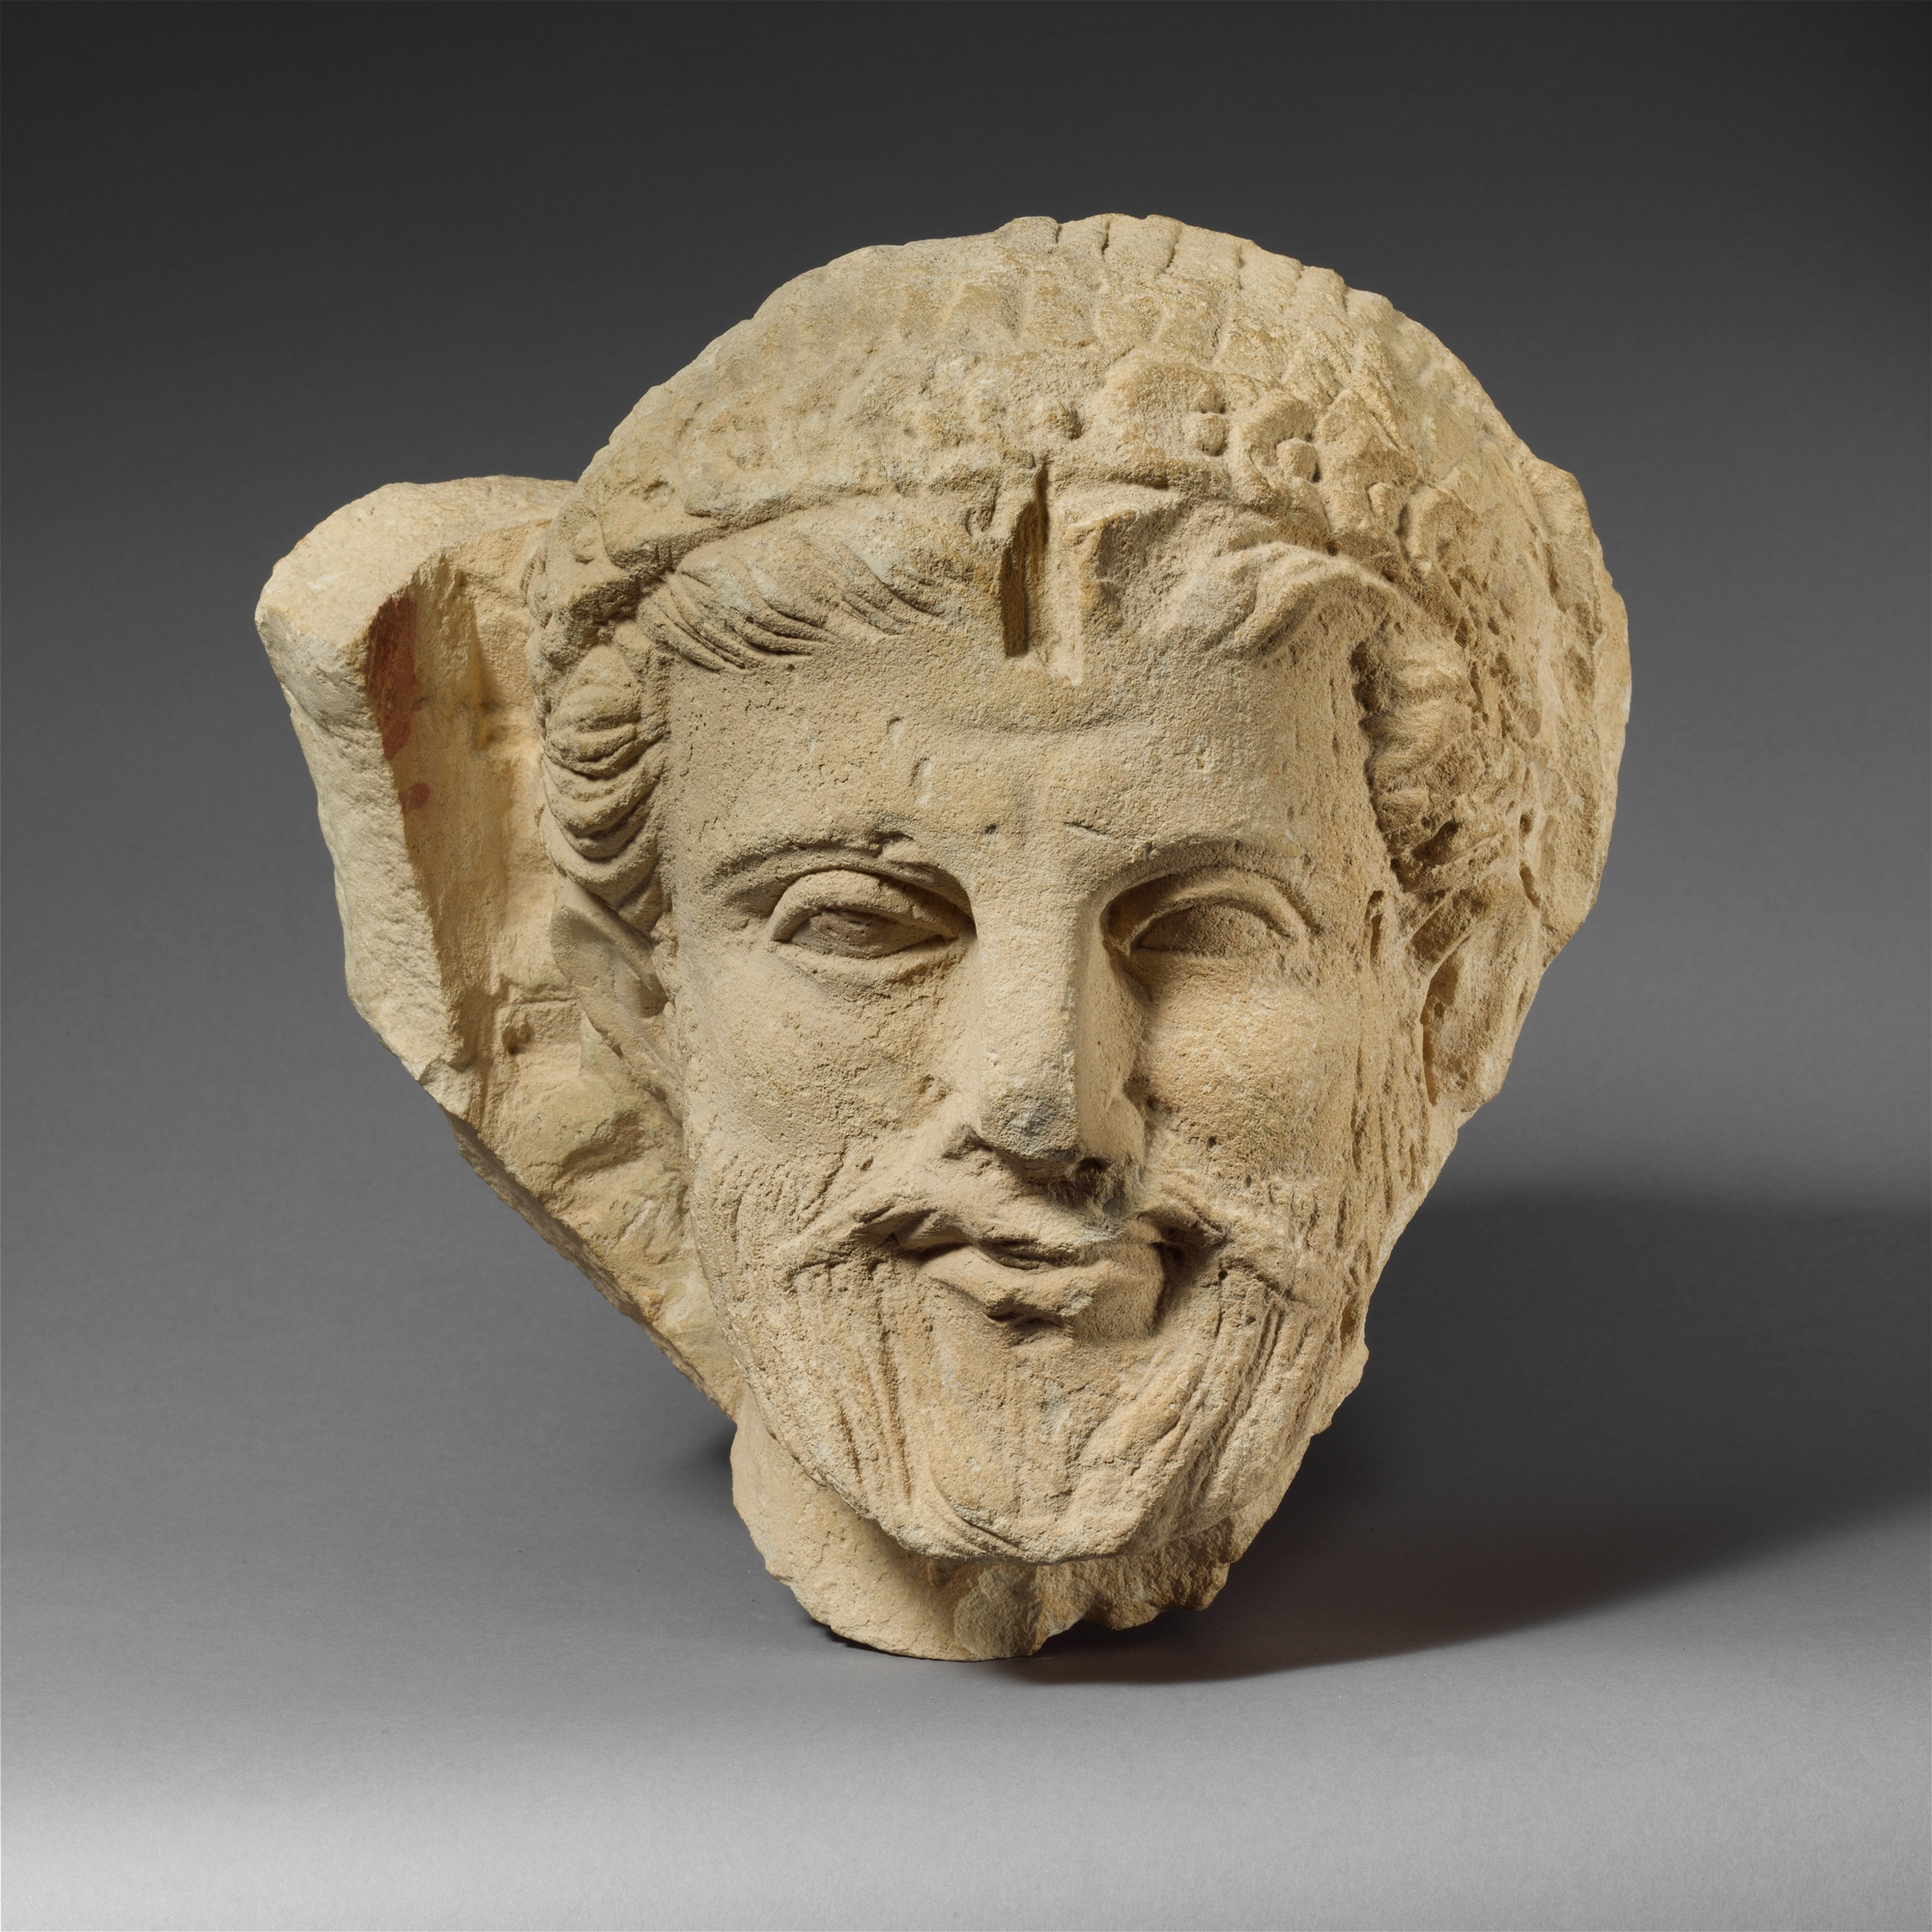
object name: head from a tombstone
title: Limestone head of a bearded man from a funerary stele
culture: cypriot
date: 3900 BCE-100 CE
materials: limestone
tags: heads,men